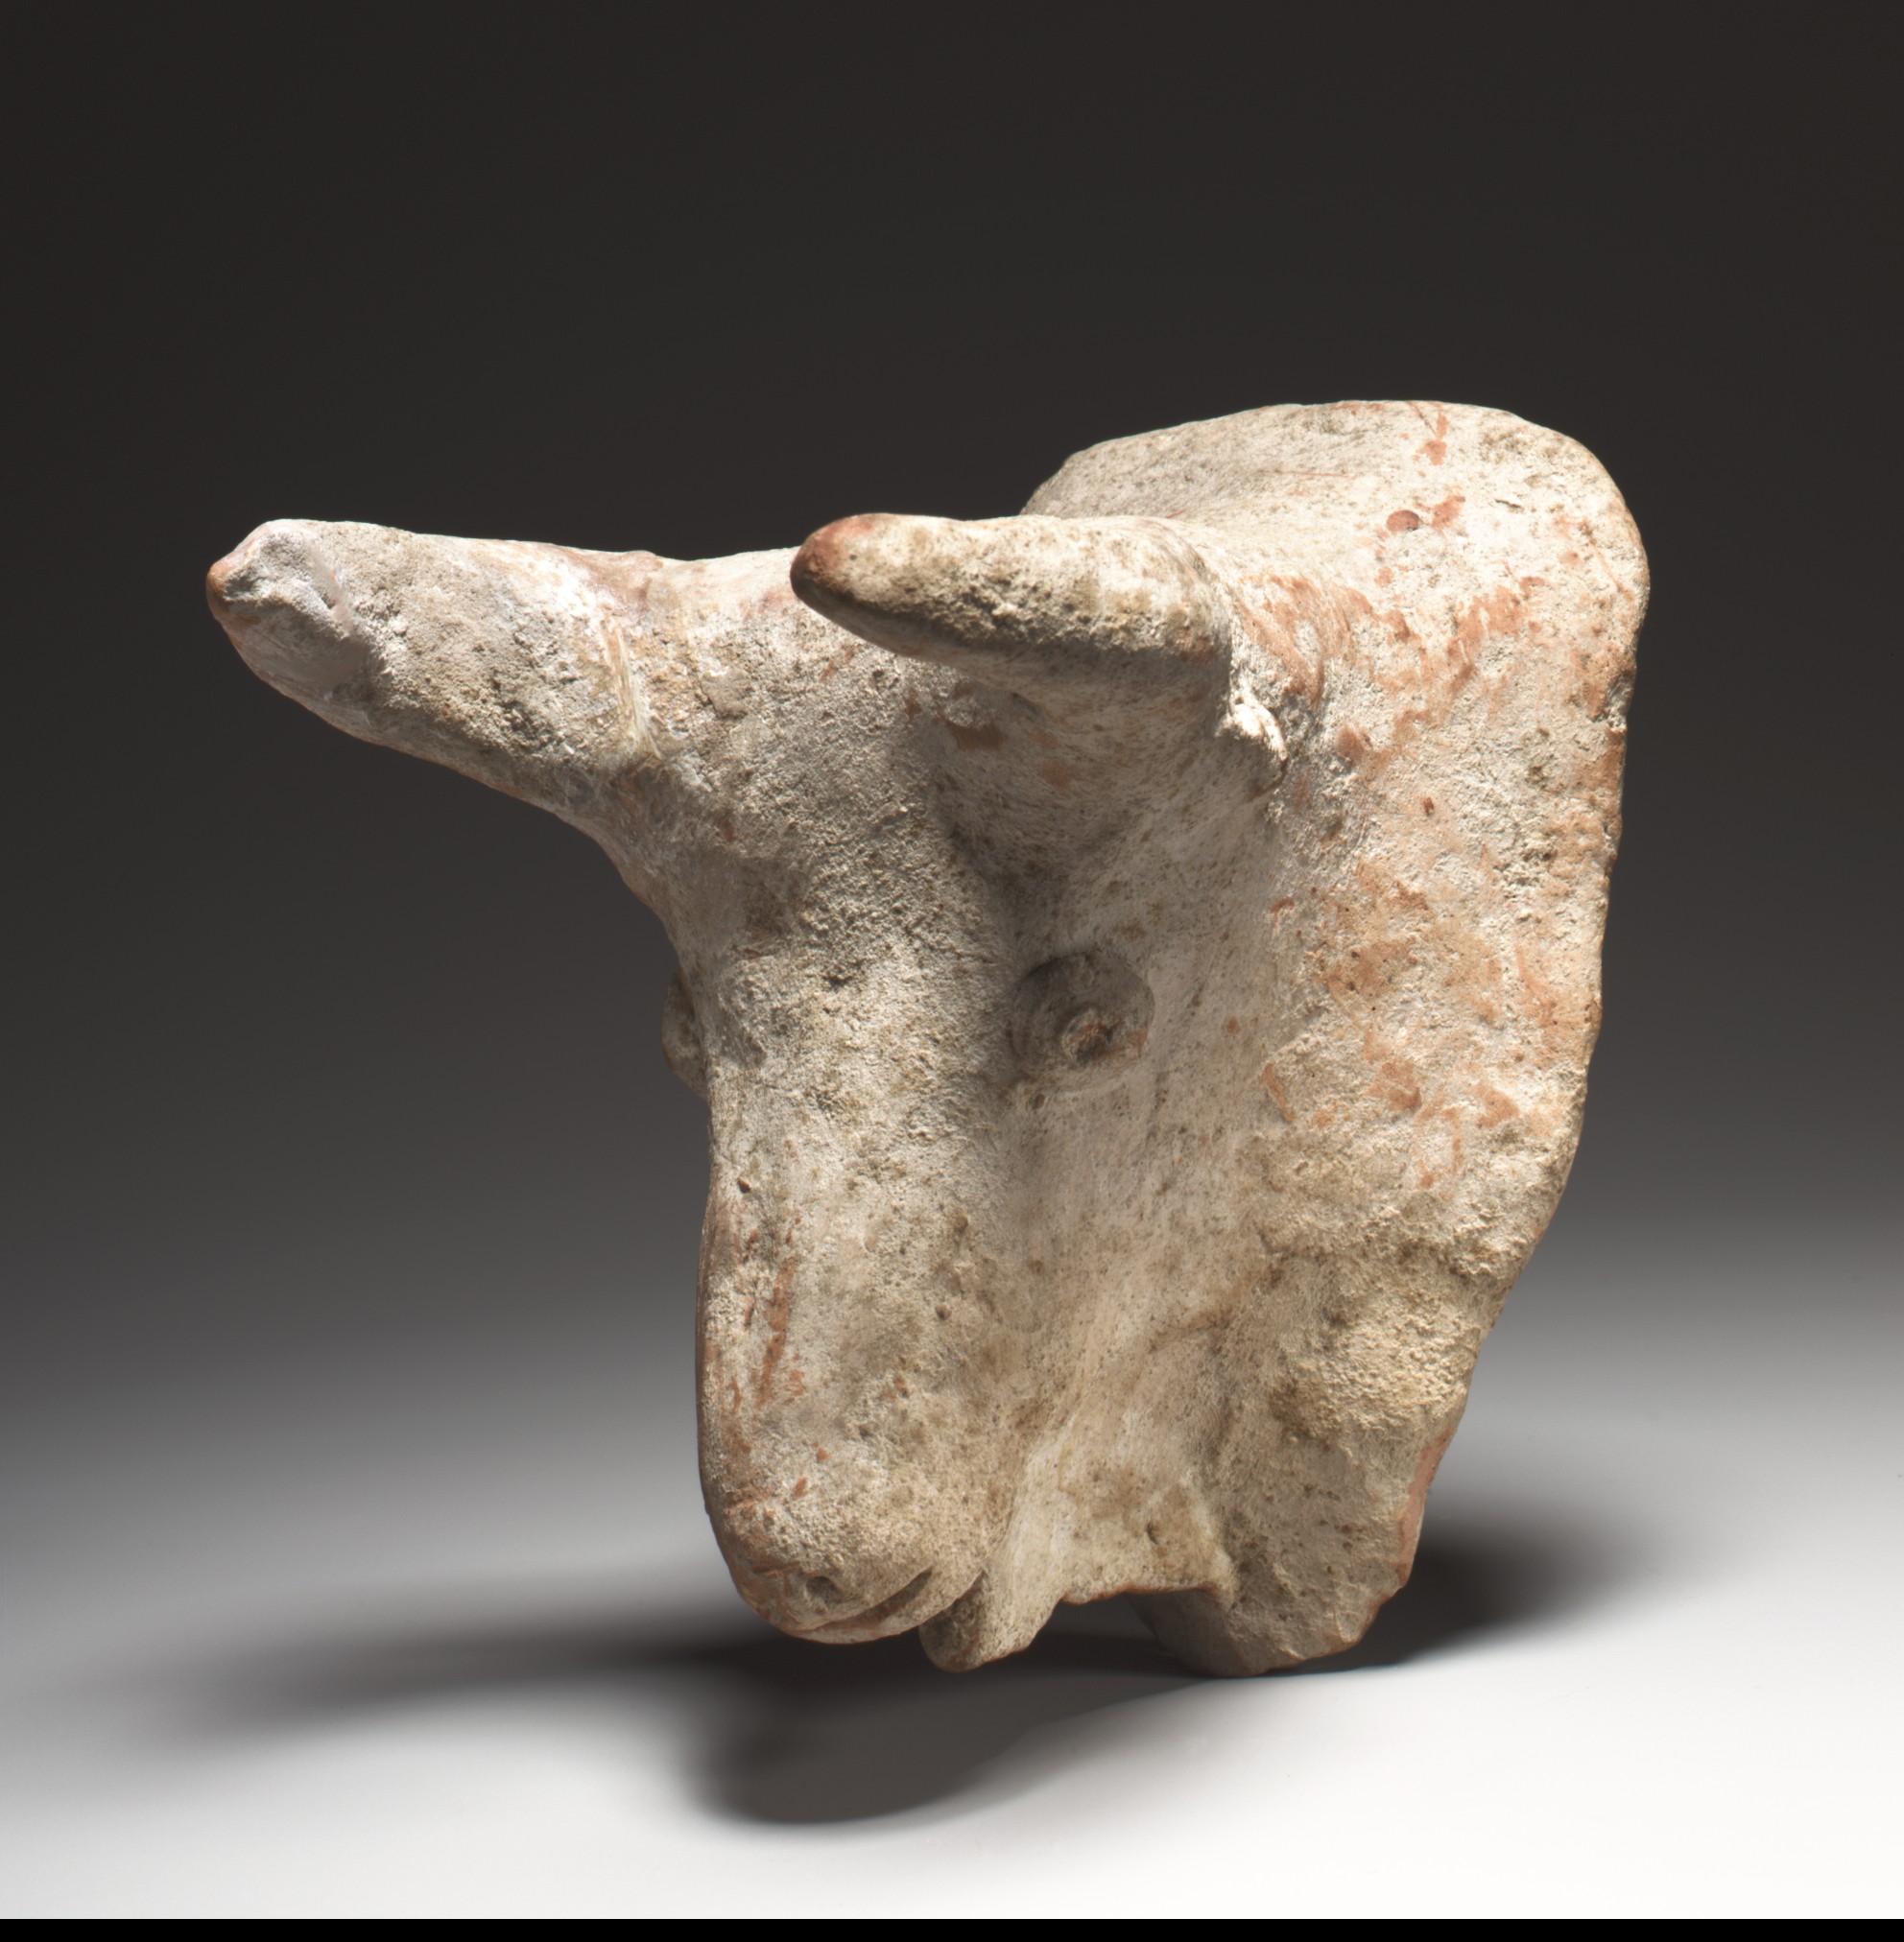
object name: mask of a bull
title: Terracotta mask in the form of a bull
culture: cypriot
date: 600-480 BCE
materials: terracotta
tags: masks,bulls